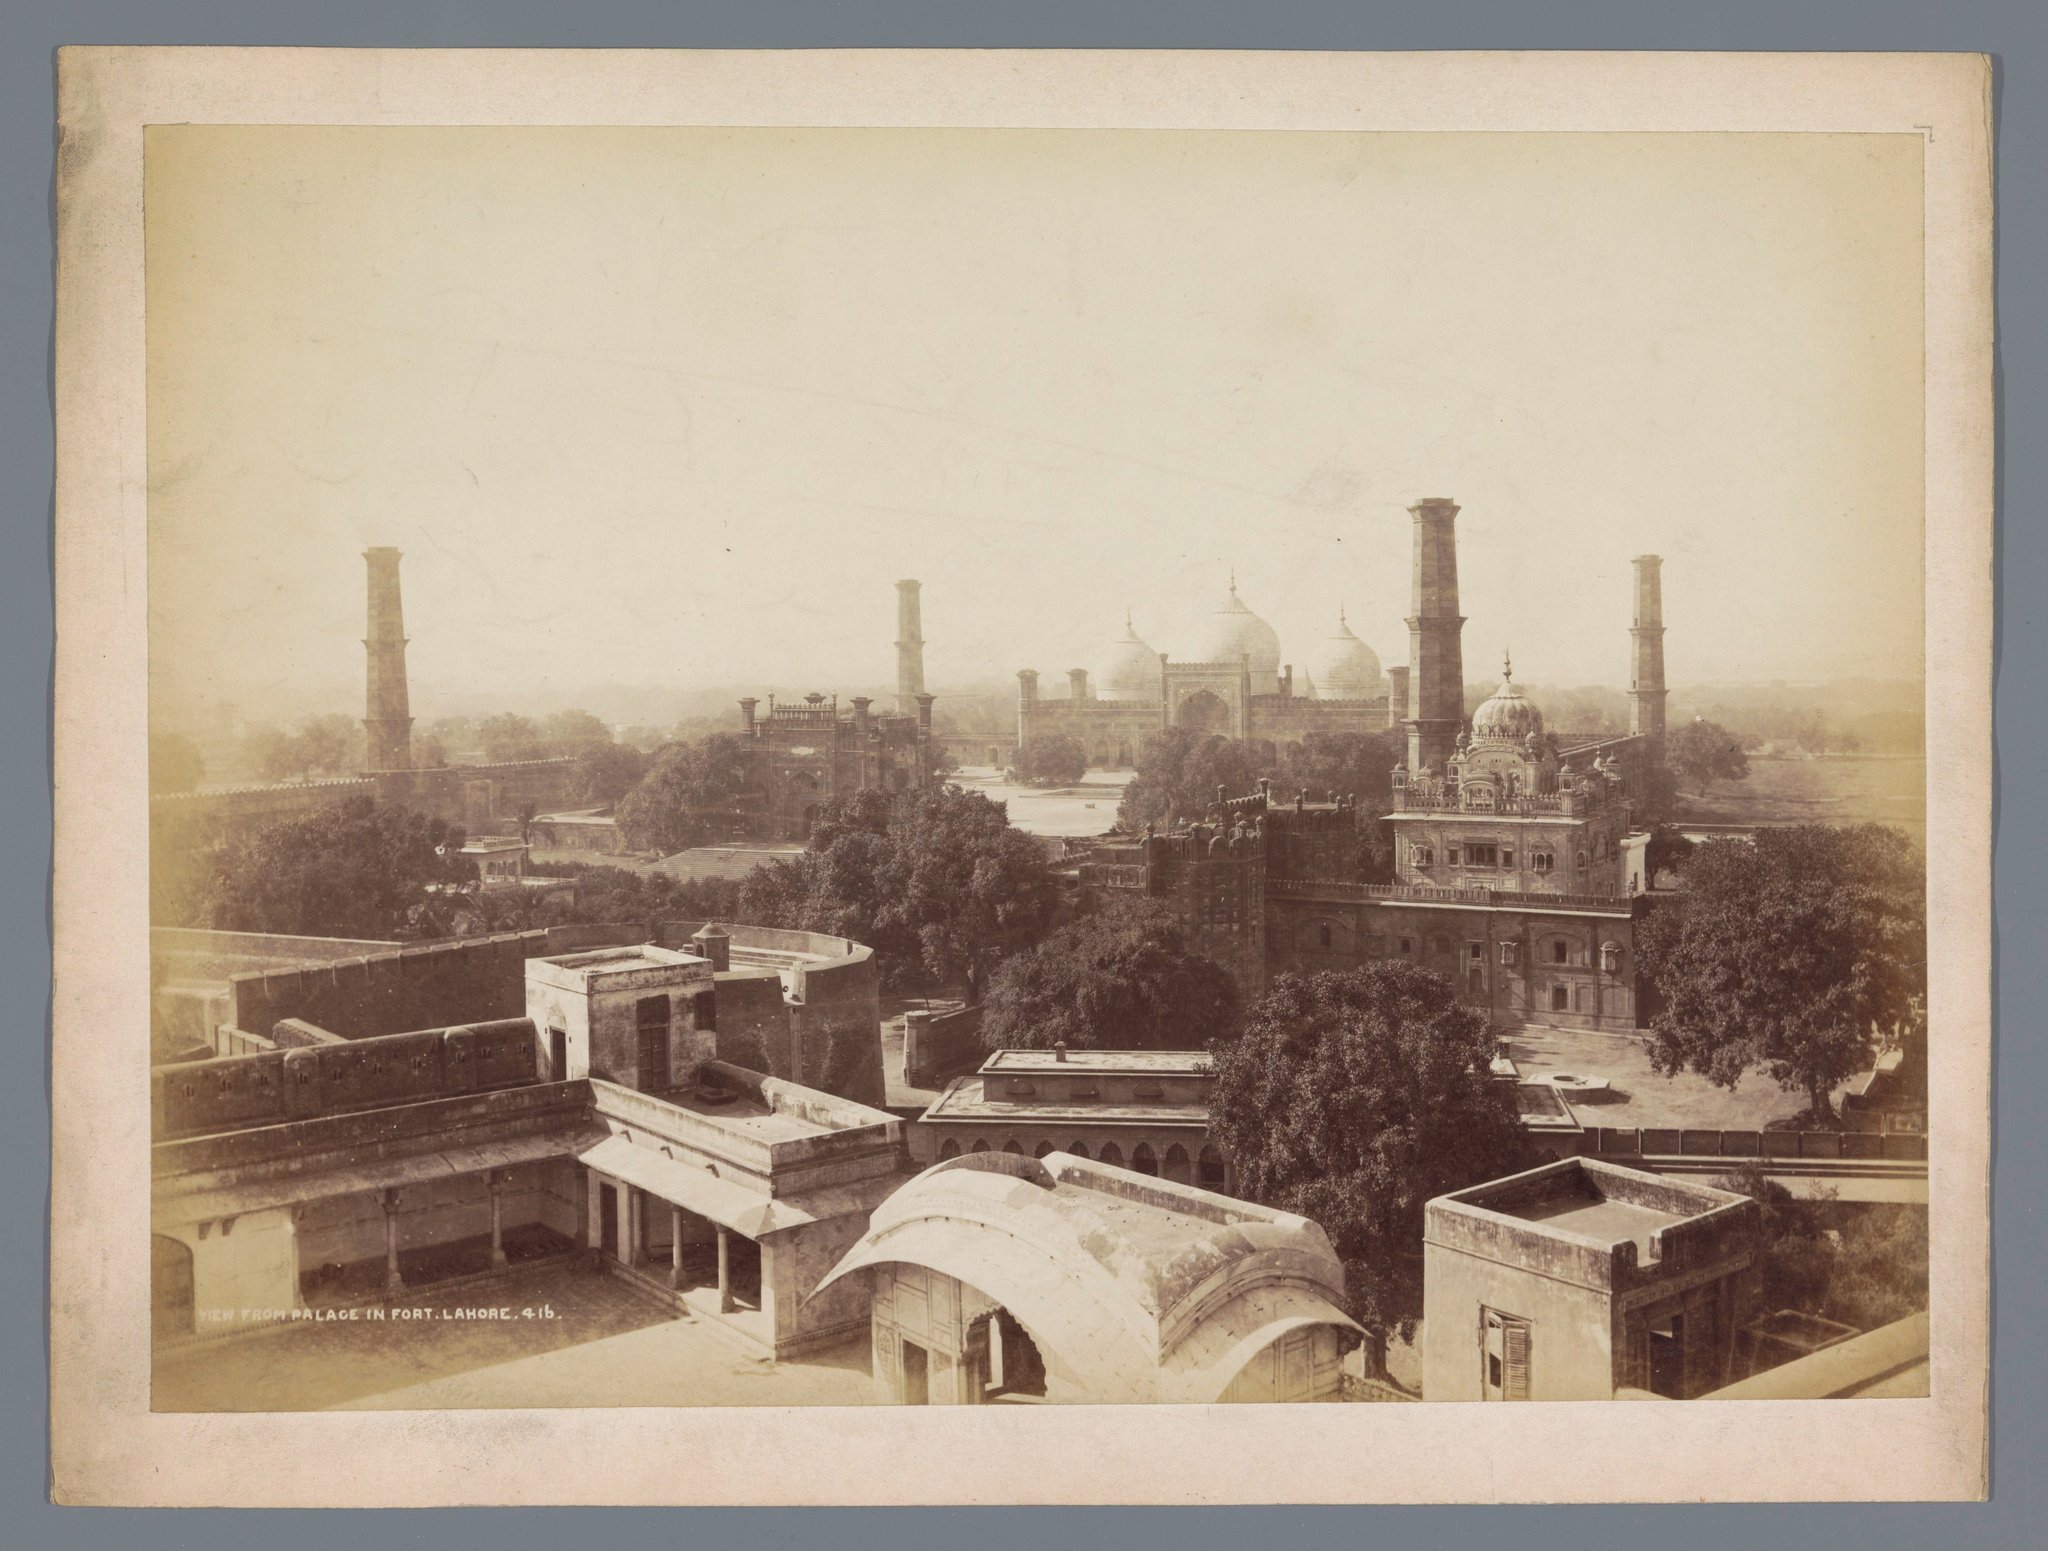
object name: photograph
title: View of the Badhshahi Masjid and the Samadhi of Ranjit Singh near the Lahore Fort, Punjab, Pakistan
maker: samuel bourne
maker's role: fotograaf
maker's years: 1834-1912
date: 1863-1870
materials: cardboard, paper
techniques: albumen print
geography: lahore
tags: mausoleum, temple, shrine ~ islam, mohammedanism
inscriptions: number: ‘20’, inscription: ‘View from Palace in Fort Lahore. 416.’